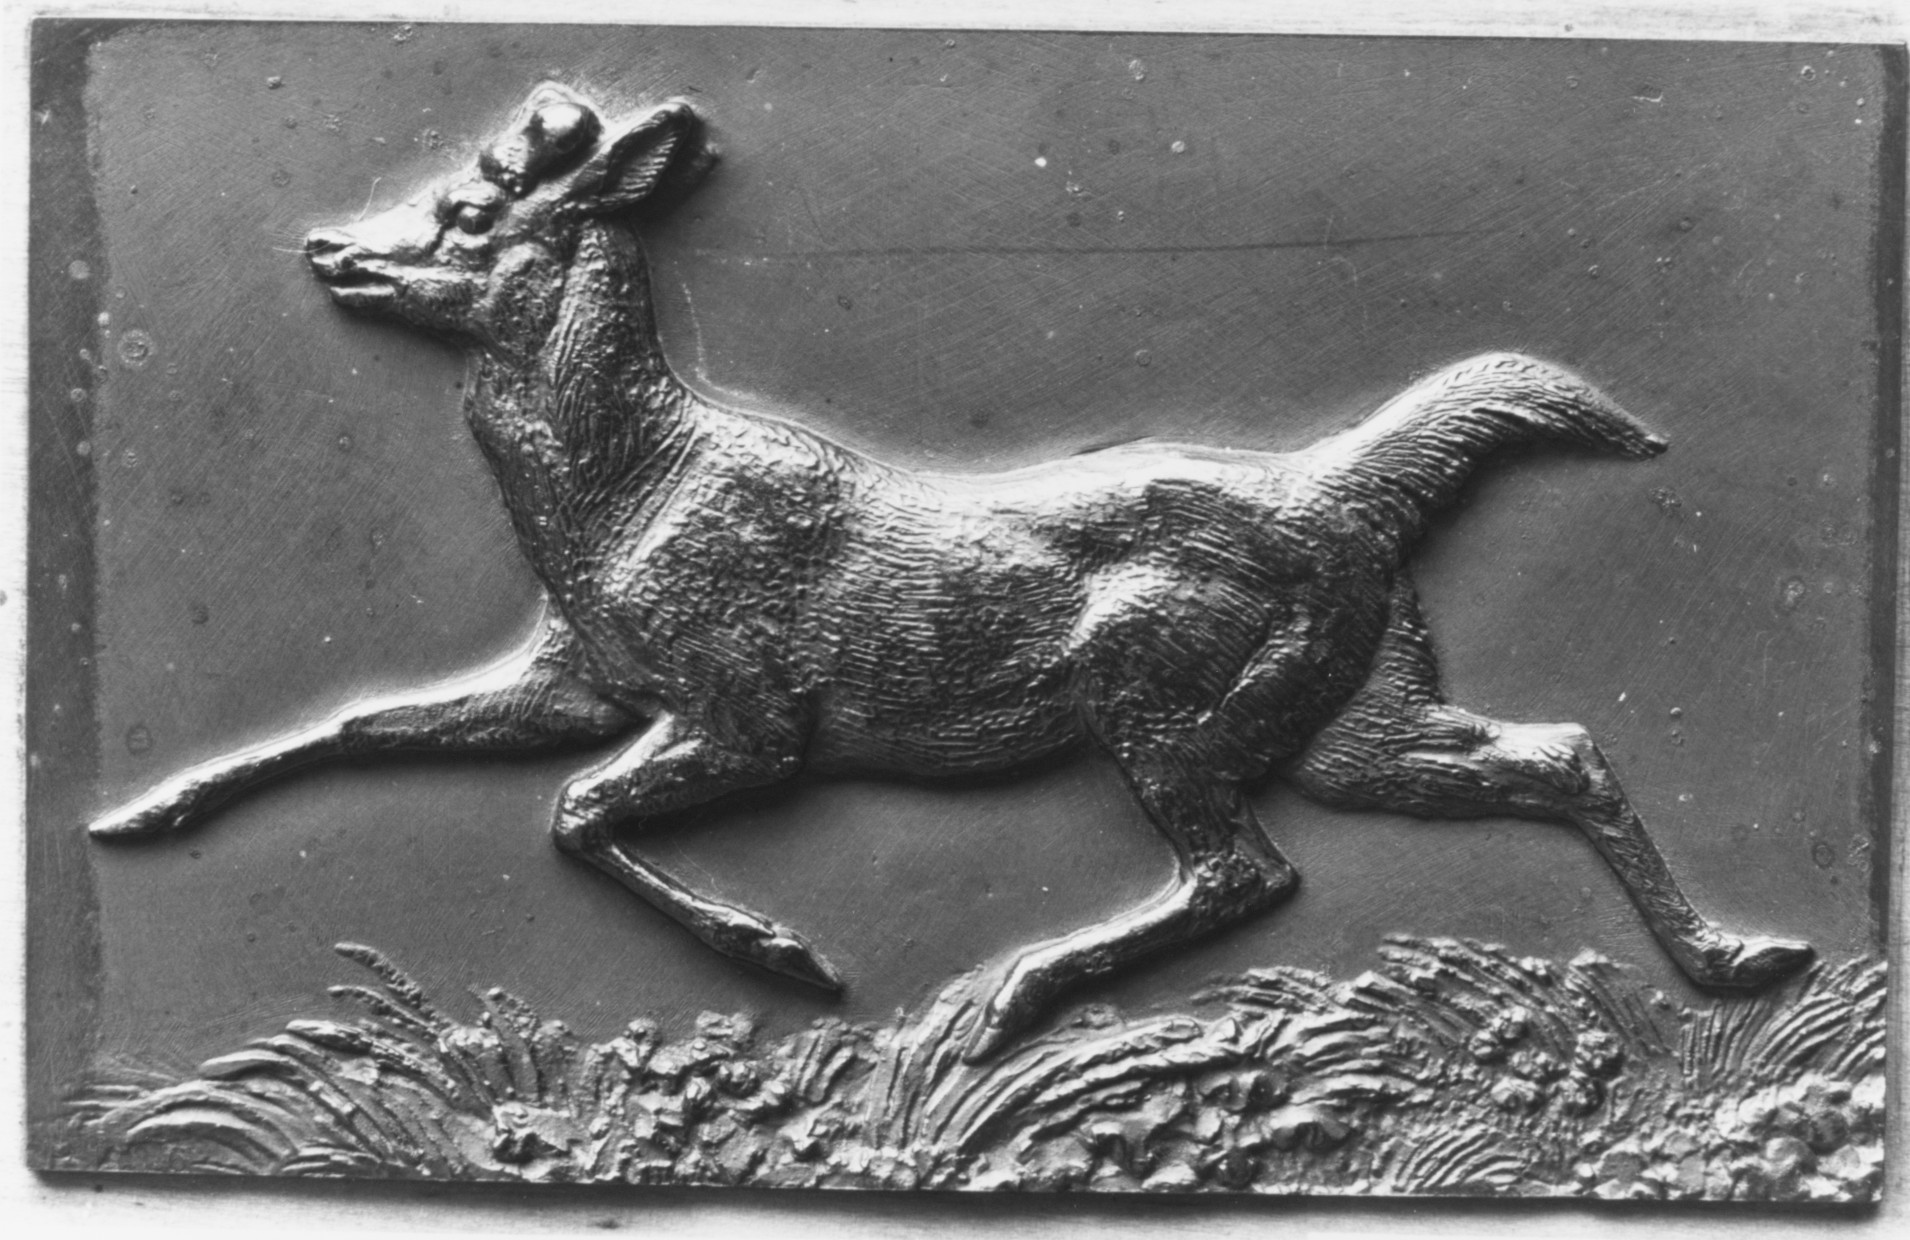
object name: plaquette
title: Virginia stag, without antlers, running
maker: antoine-louis barye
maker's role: artist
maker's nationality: french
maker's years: 1795-1875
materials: bronze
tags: deer